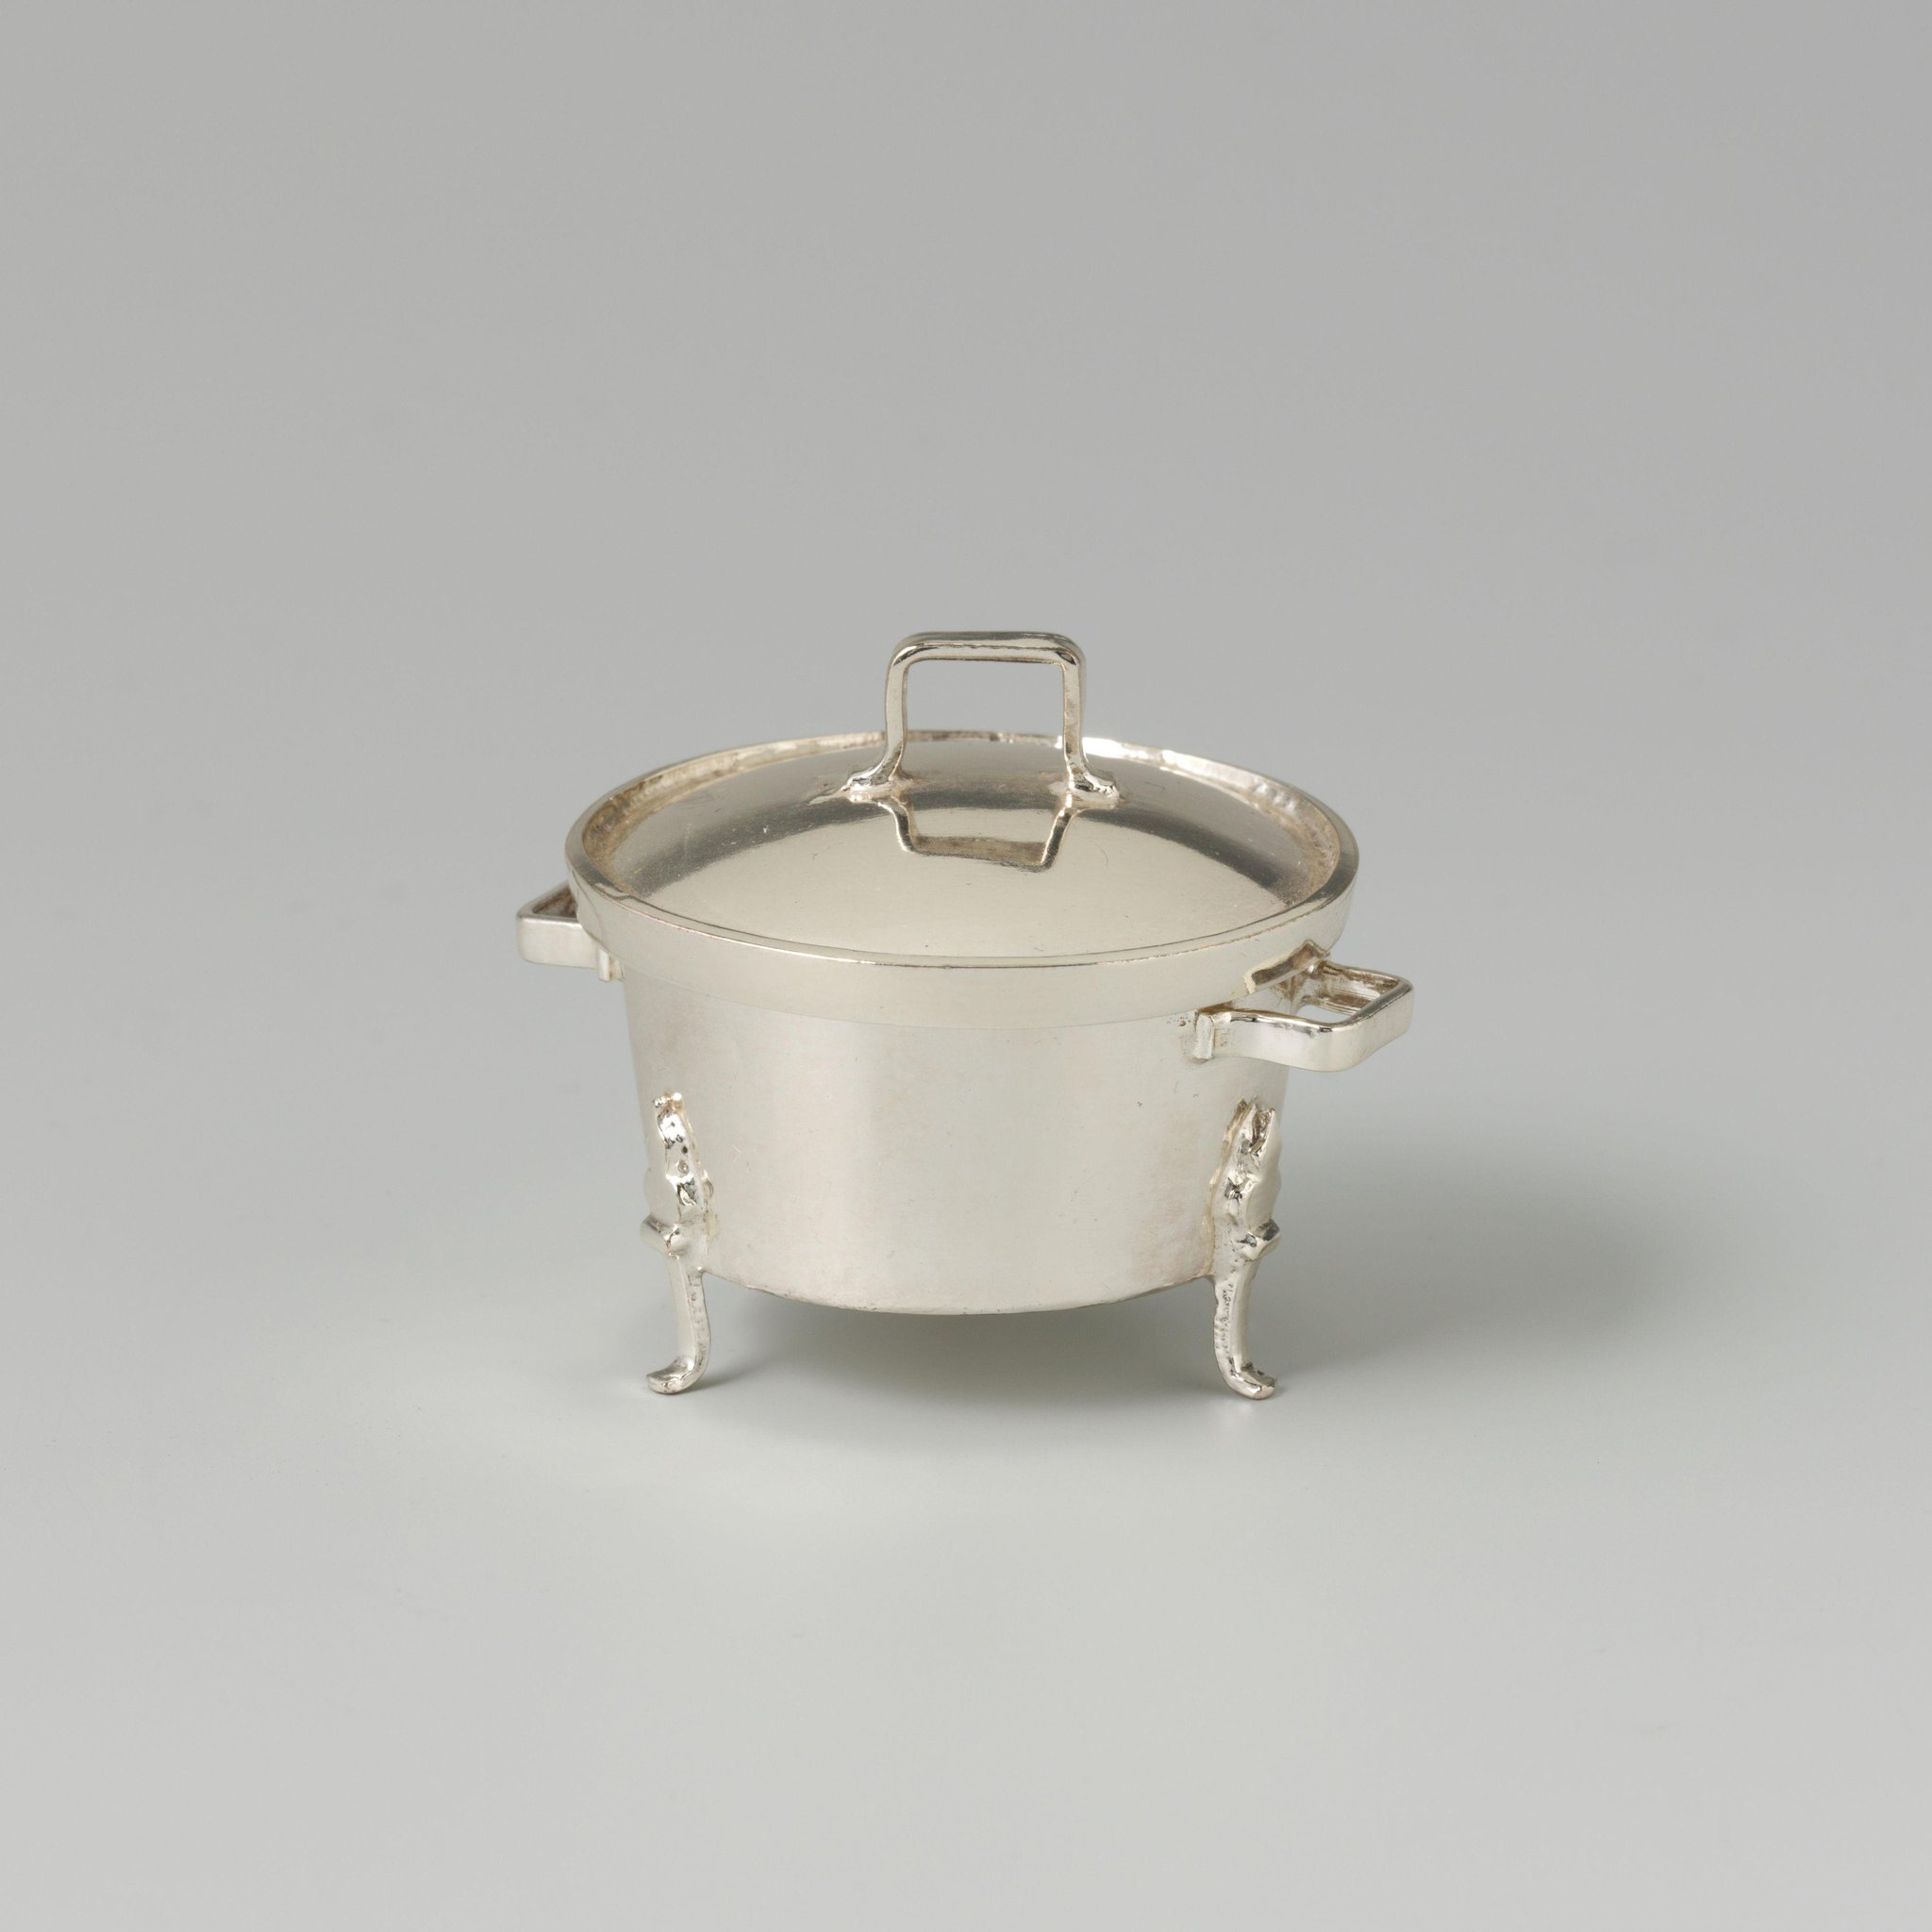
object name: boiler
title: Kookpan of kookketel van zilver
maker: Anonymous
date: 1675-1725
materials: silver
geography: amsterdam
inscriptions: maker's mark: ‘gekroond klaverblad met steel in eivorm?’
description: Kookpan of kookketel van zilver, cilindervormige bak op drie hoge poten met bladversiering vastgezet op de bak, twee handvatten opzij, losse overkragende deksel met handvat bovenop